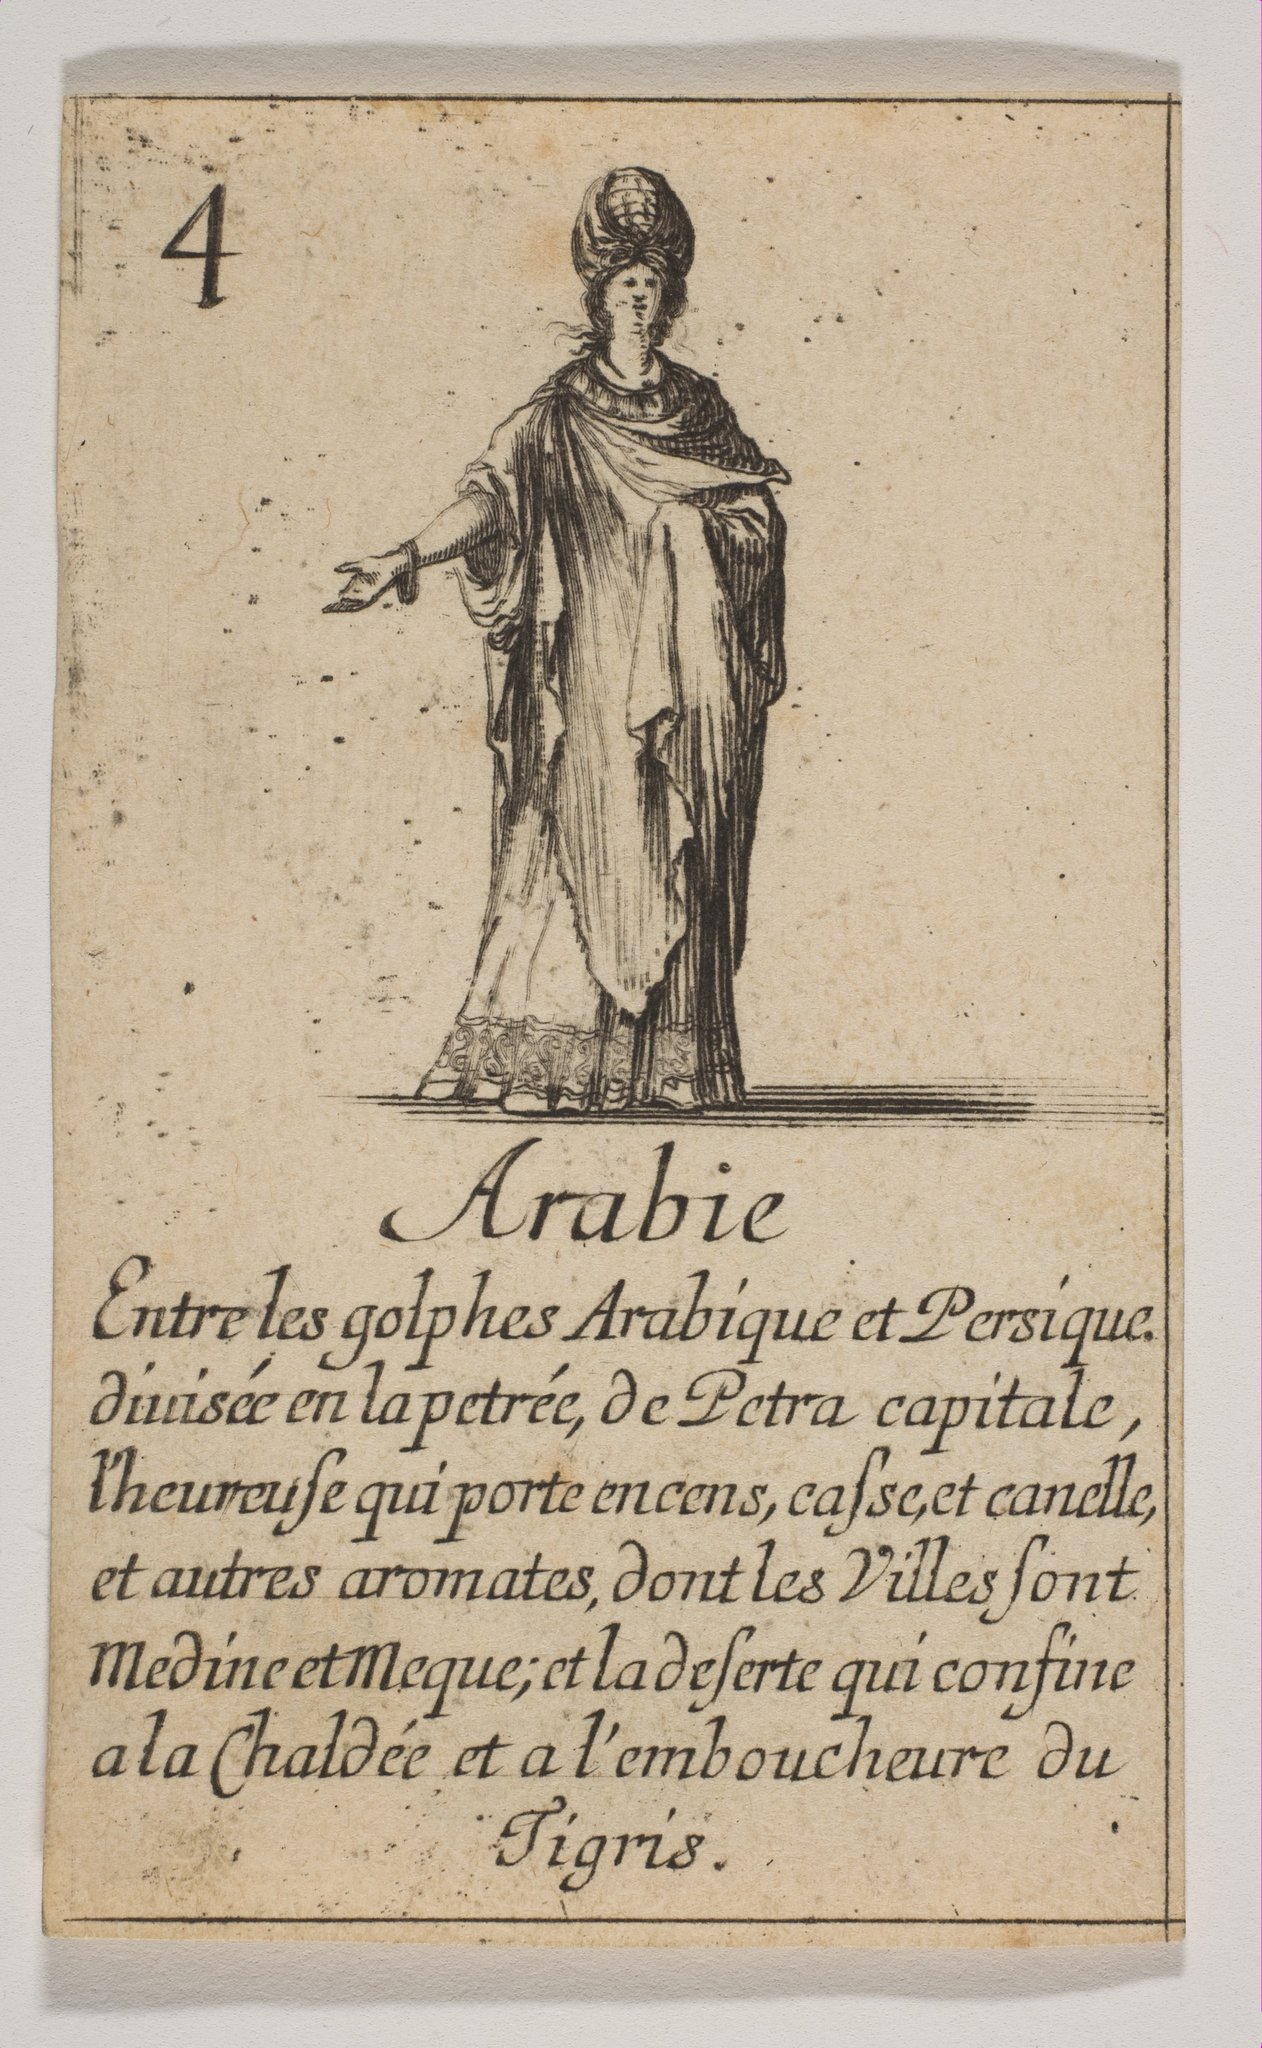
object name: print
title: Arabie, from "Jeu de la Géographie"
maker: stefano della bella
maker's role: artist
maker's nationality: italian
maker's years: 1610-1664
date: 1644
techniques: etching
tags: women